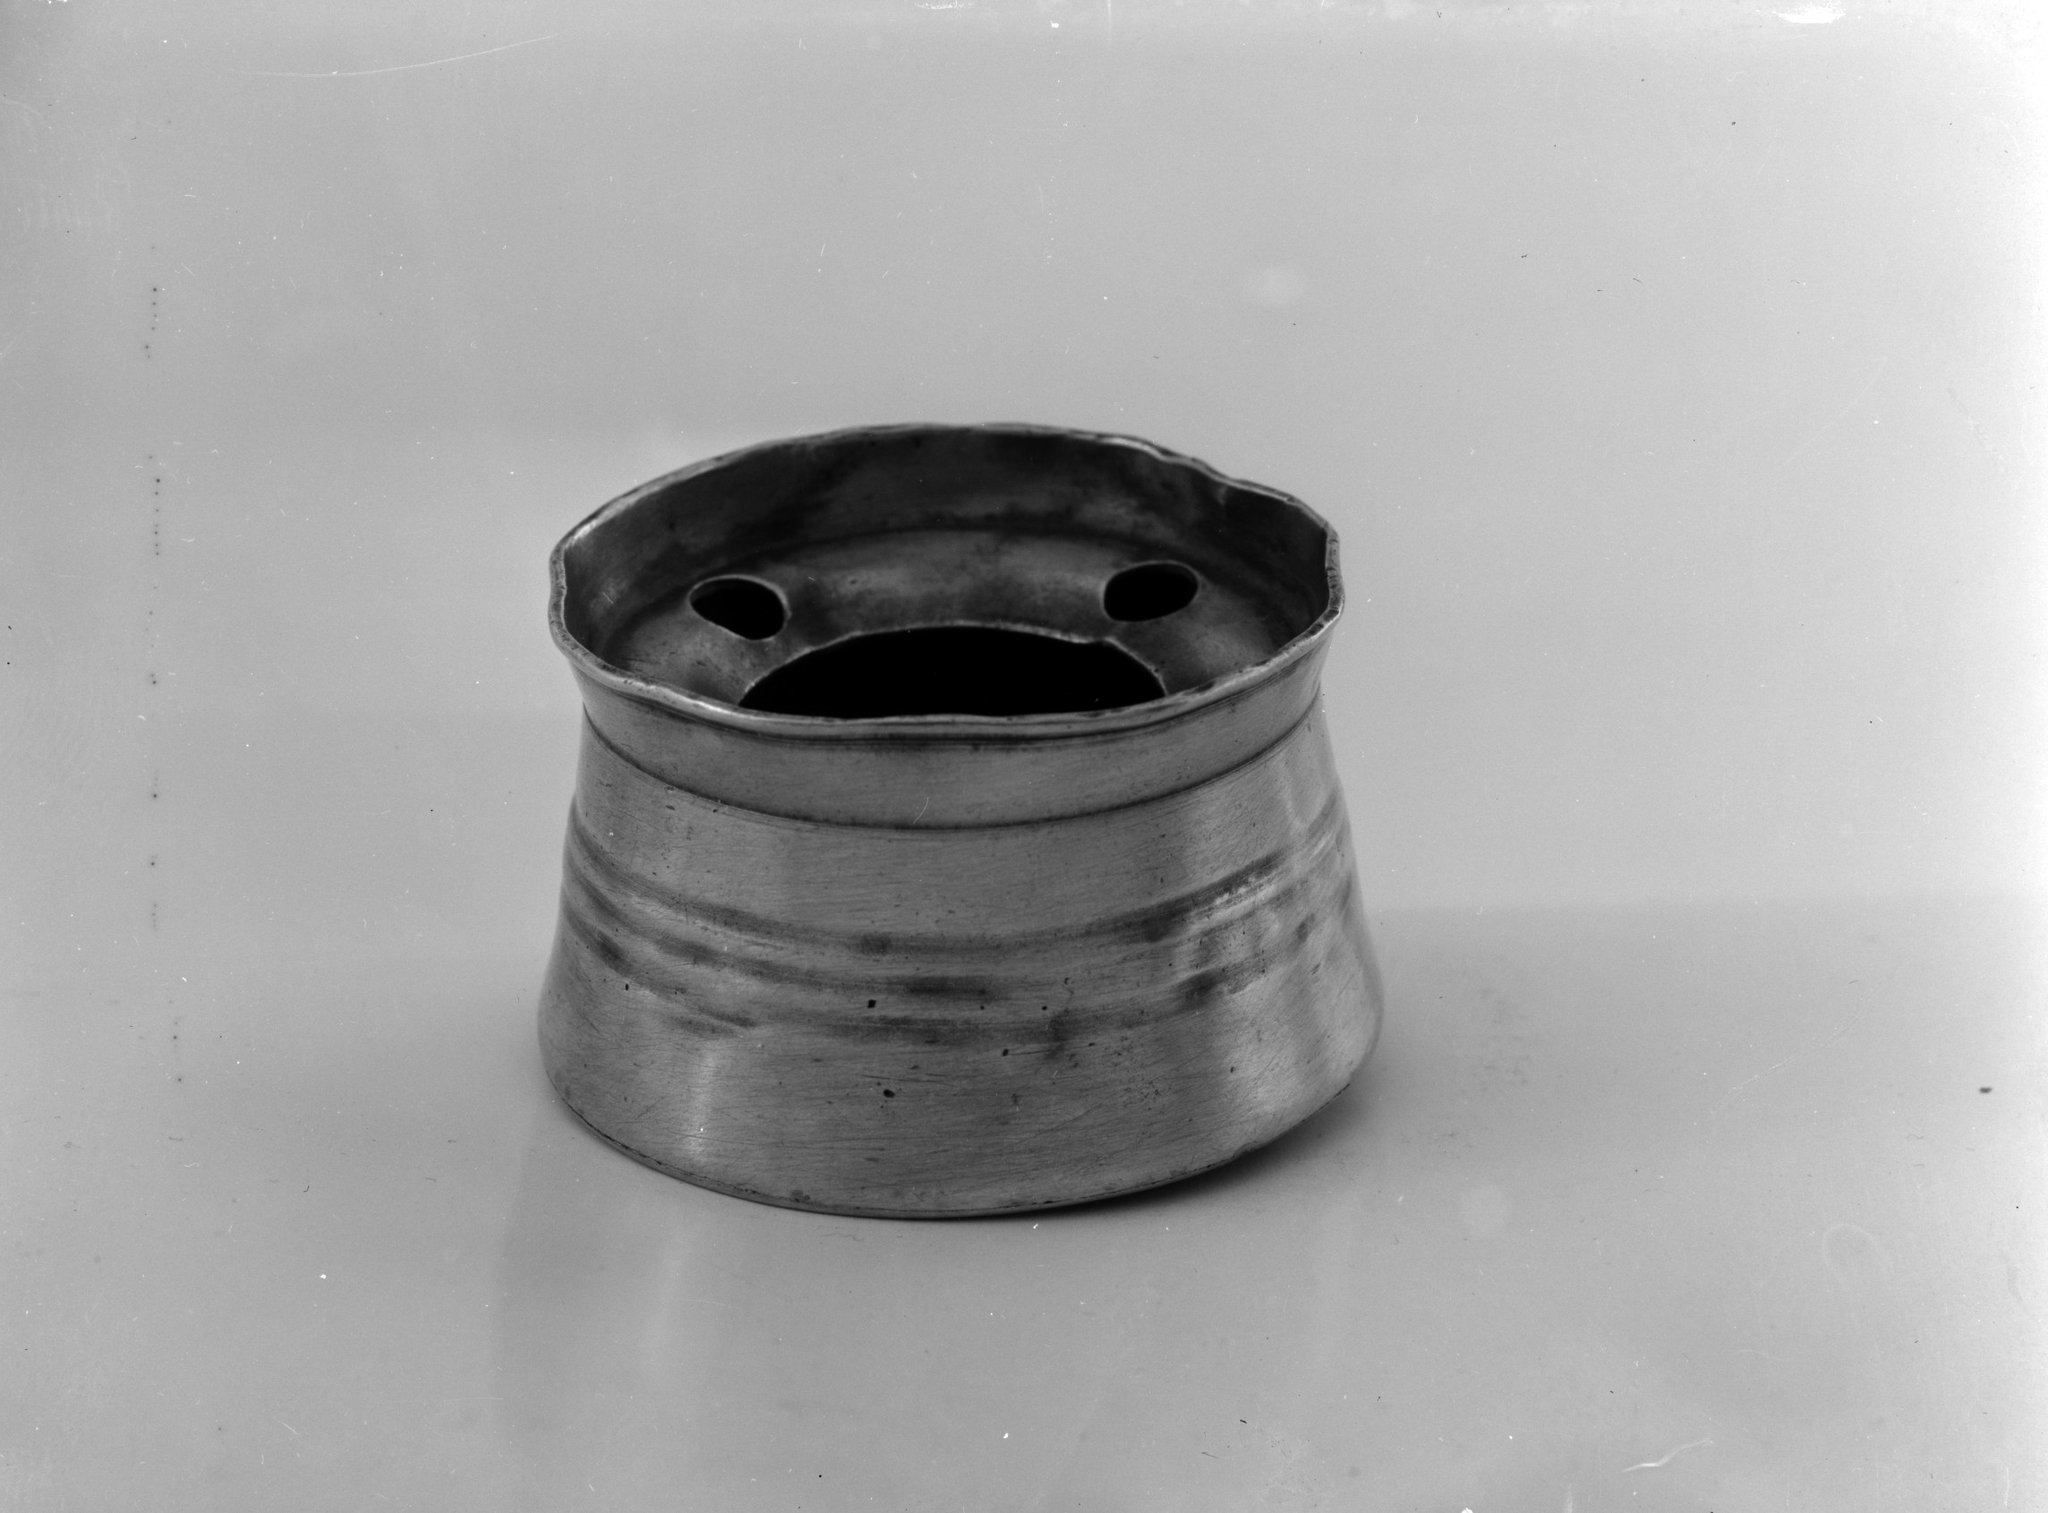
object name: inkwell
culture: american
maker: thomas danforth, iii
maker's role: maker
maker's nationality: american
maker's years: 1756-1840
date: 1807-1813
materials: pewter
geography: united states